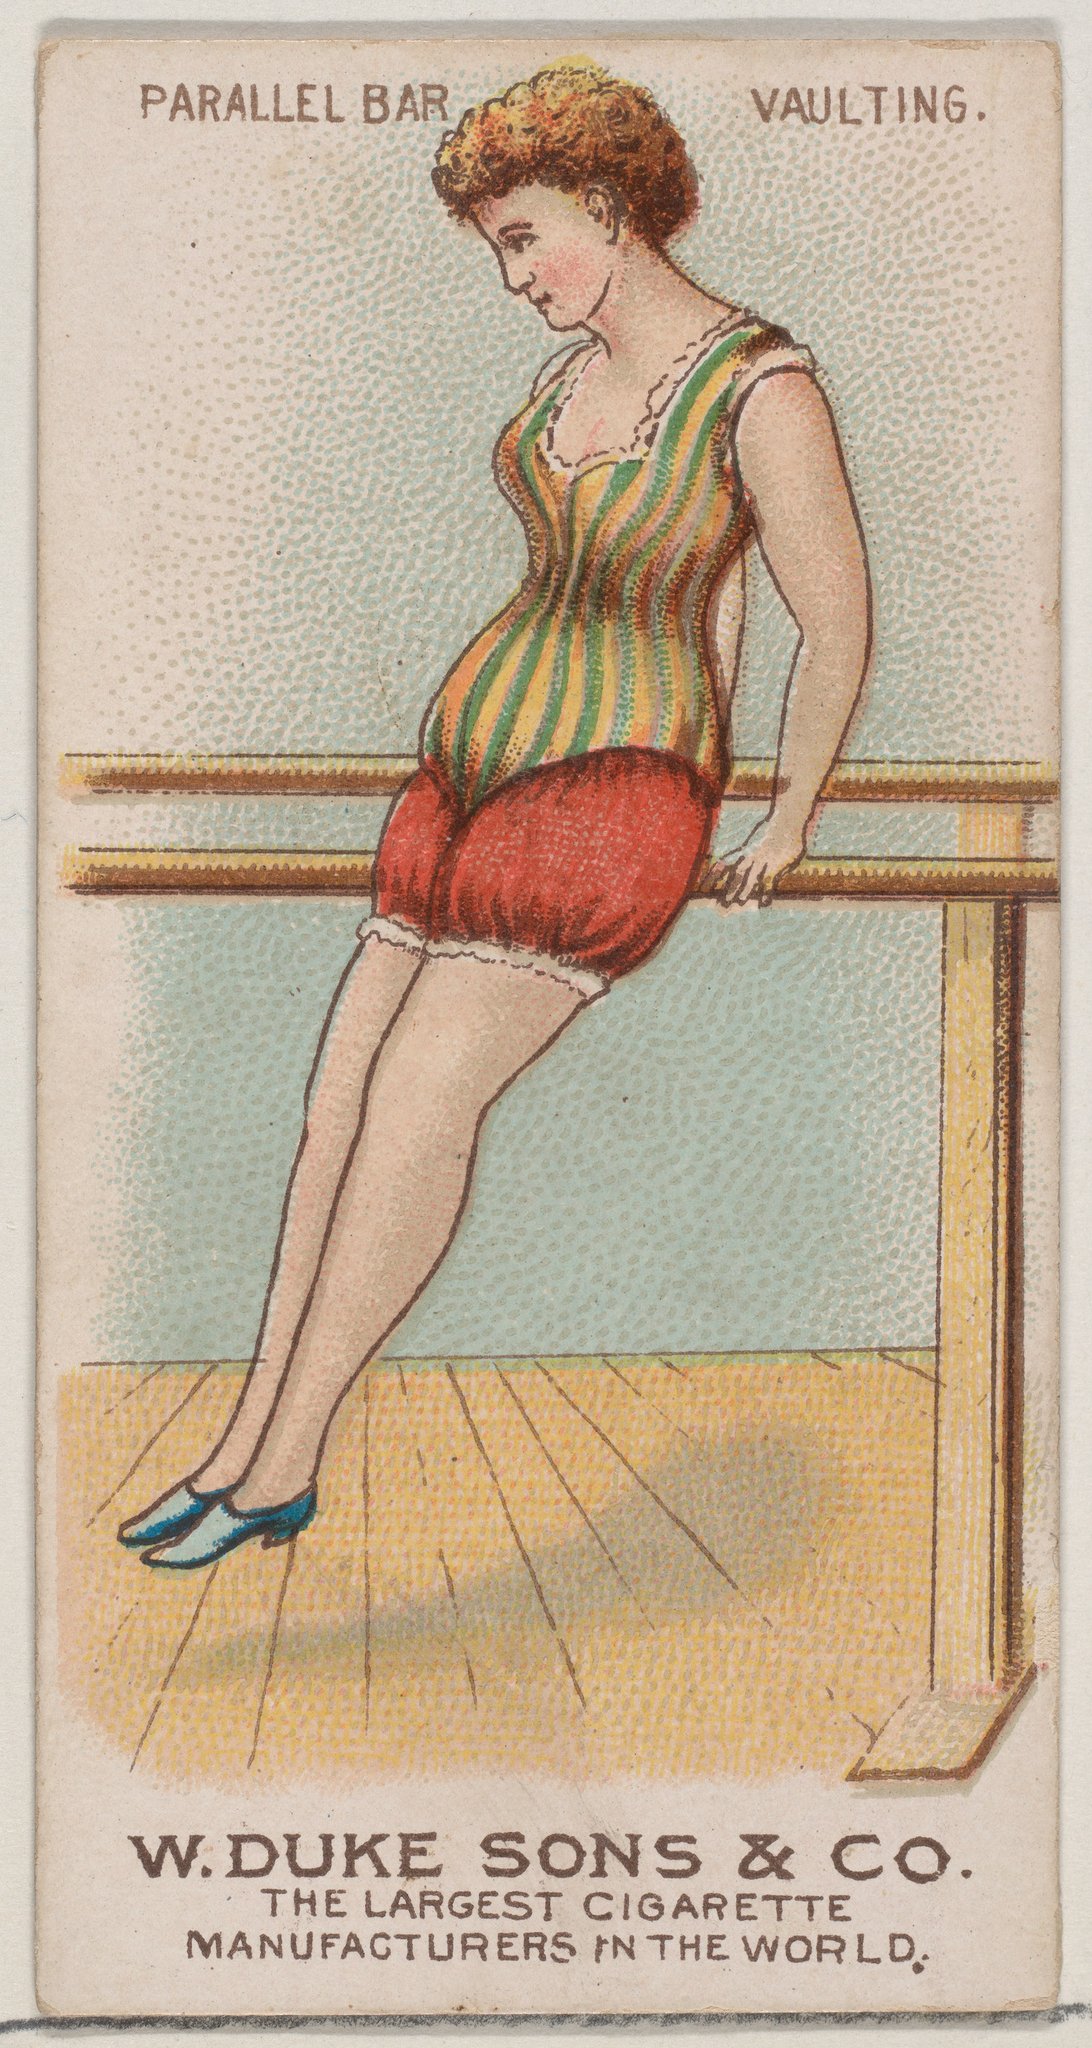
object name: print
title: Parallel Bars, Vaulting, from the Gymnastic Exercises series (N77) for Duke brand cigarettes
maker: w. duke, sons & co.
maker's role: publisher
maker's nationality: american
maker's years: 1870-1920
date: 1887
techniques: color lithograph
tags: women,sports,athletes